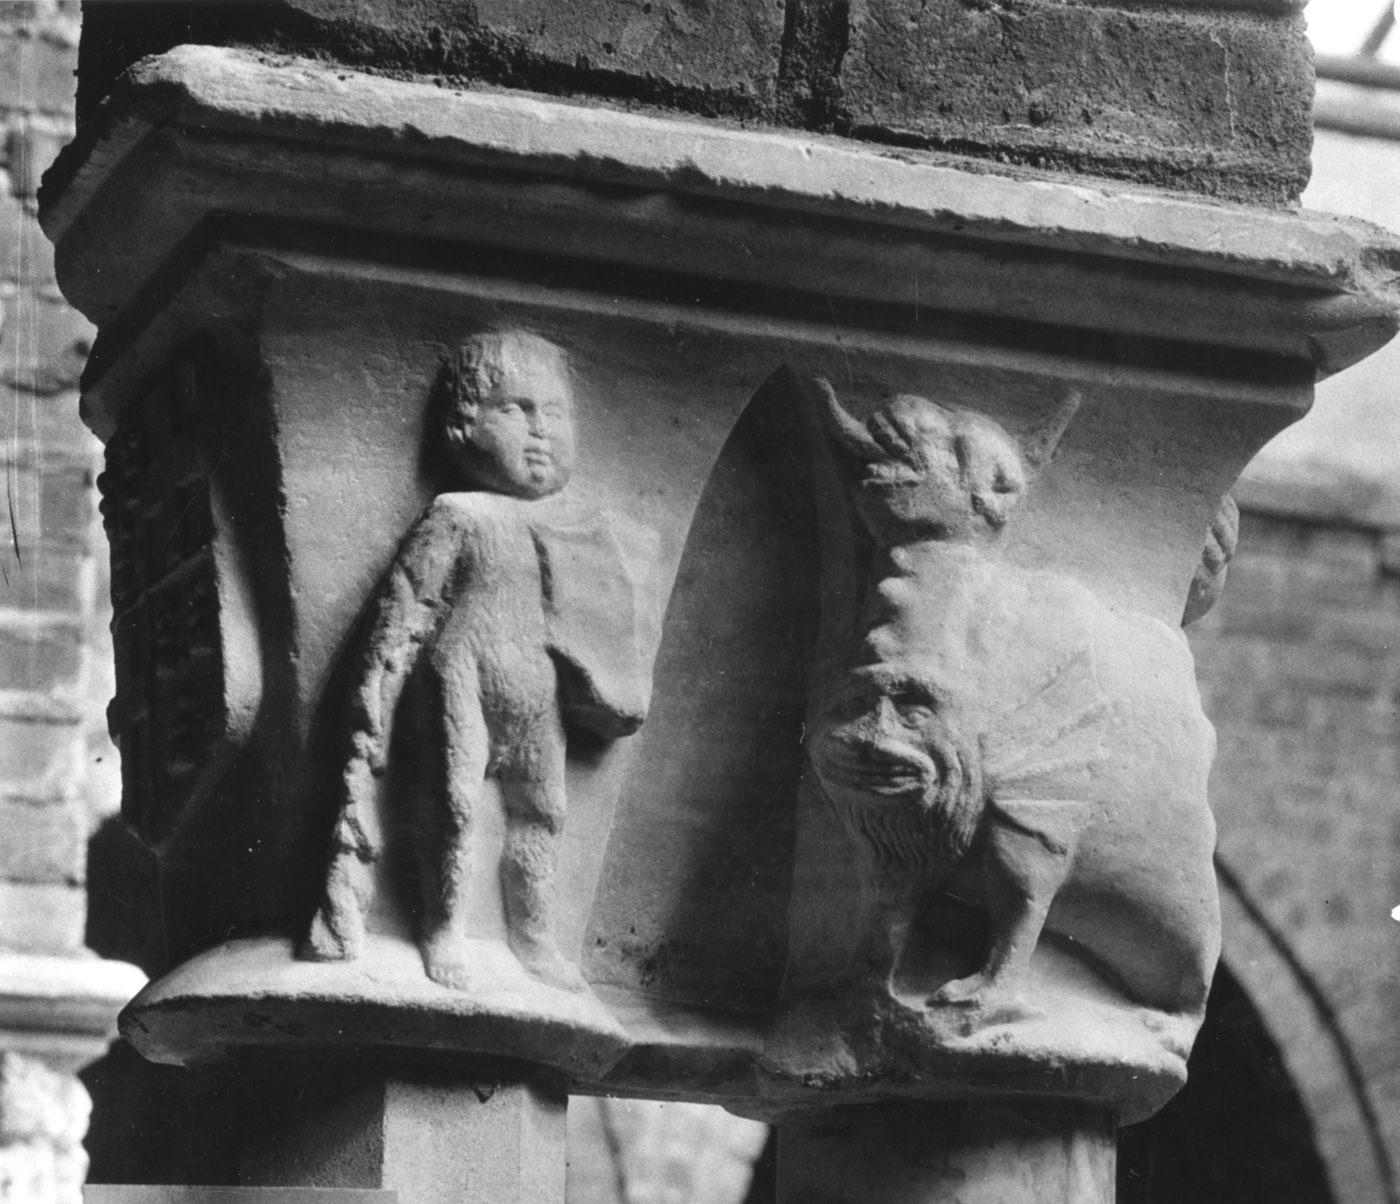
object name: capital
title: Double Capital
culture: french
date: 1467-1500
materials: marble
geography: france